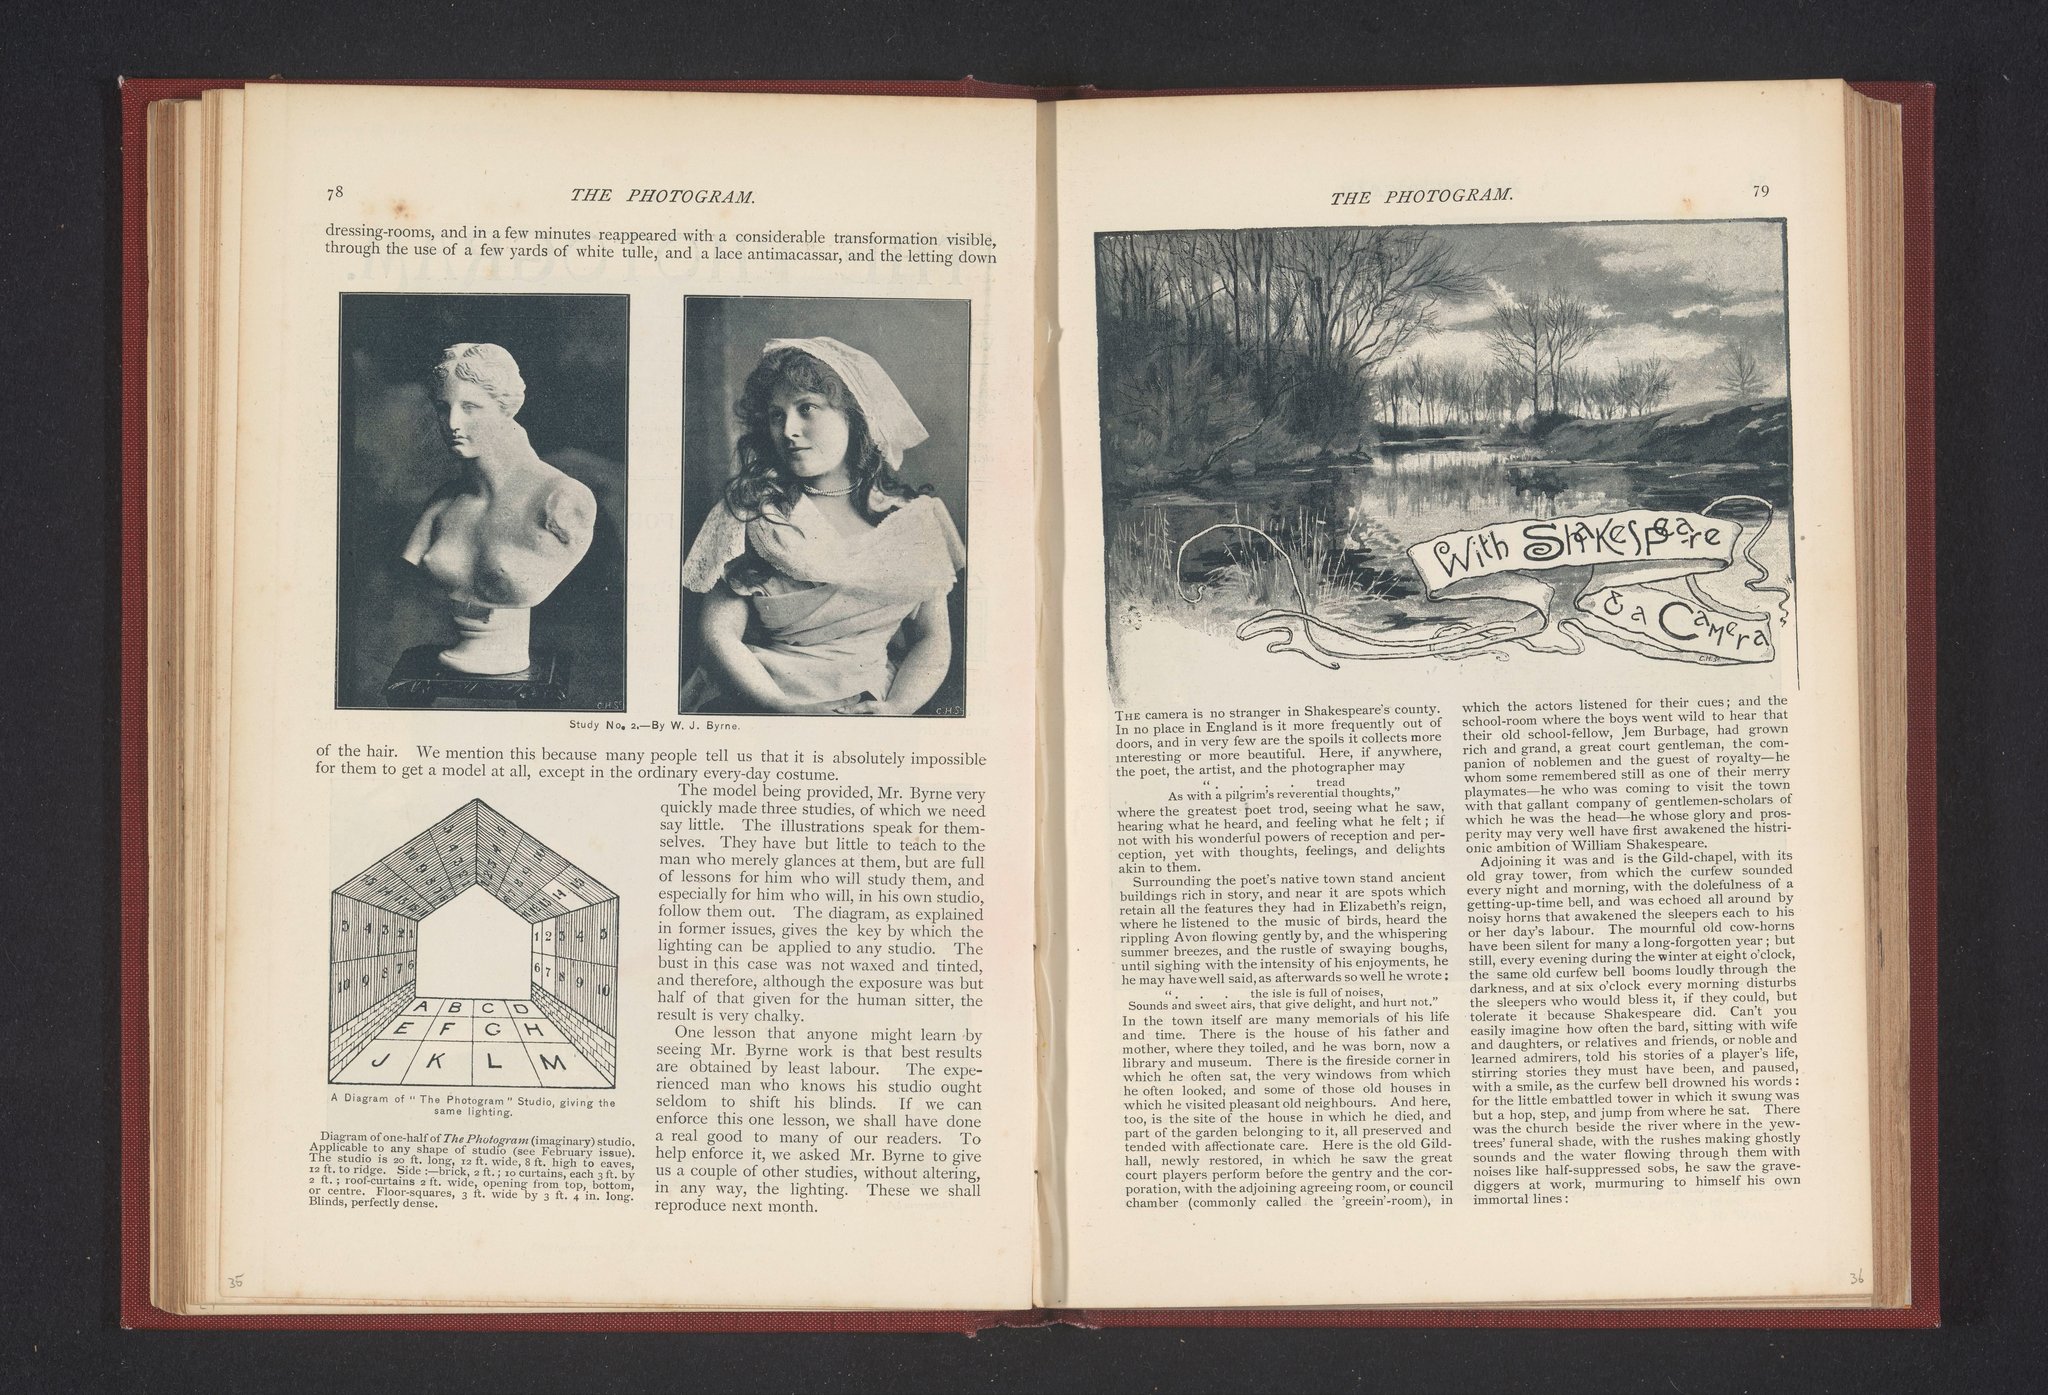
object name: page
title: Twee studies van W.J. Byrne, buste en portret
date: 1889-1894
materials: paper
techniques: autotype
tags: chest, bust, historical persons - bb - woman